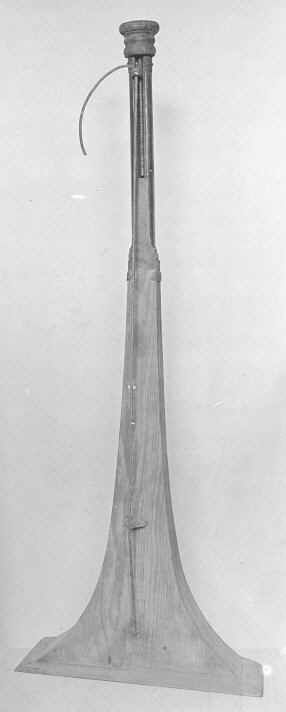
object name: tromba marina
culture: german or swiss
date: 1801-1900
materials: wood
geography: germany